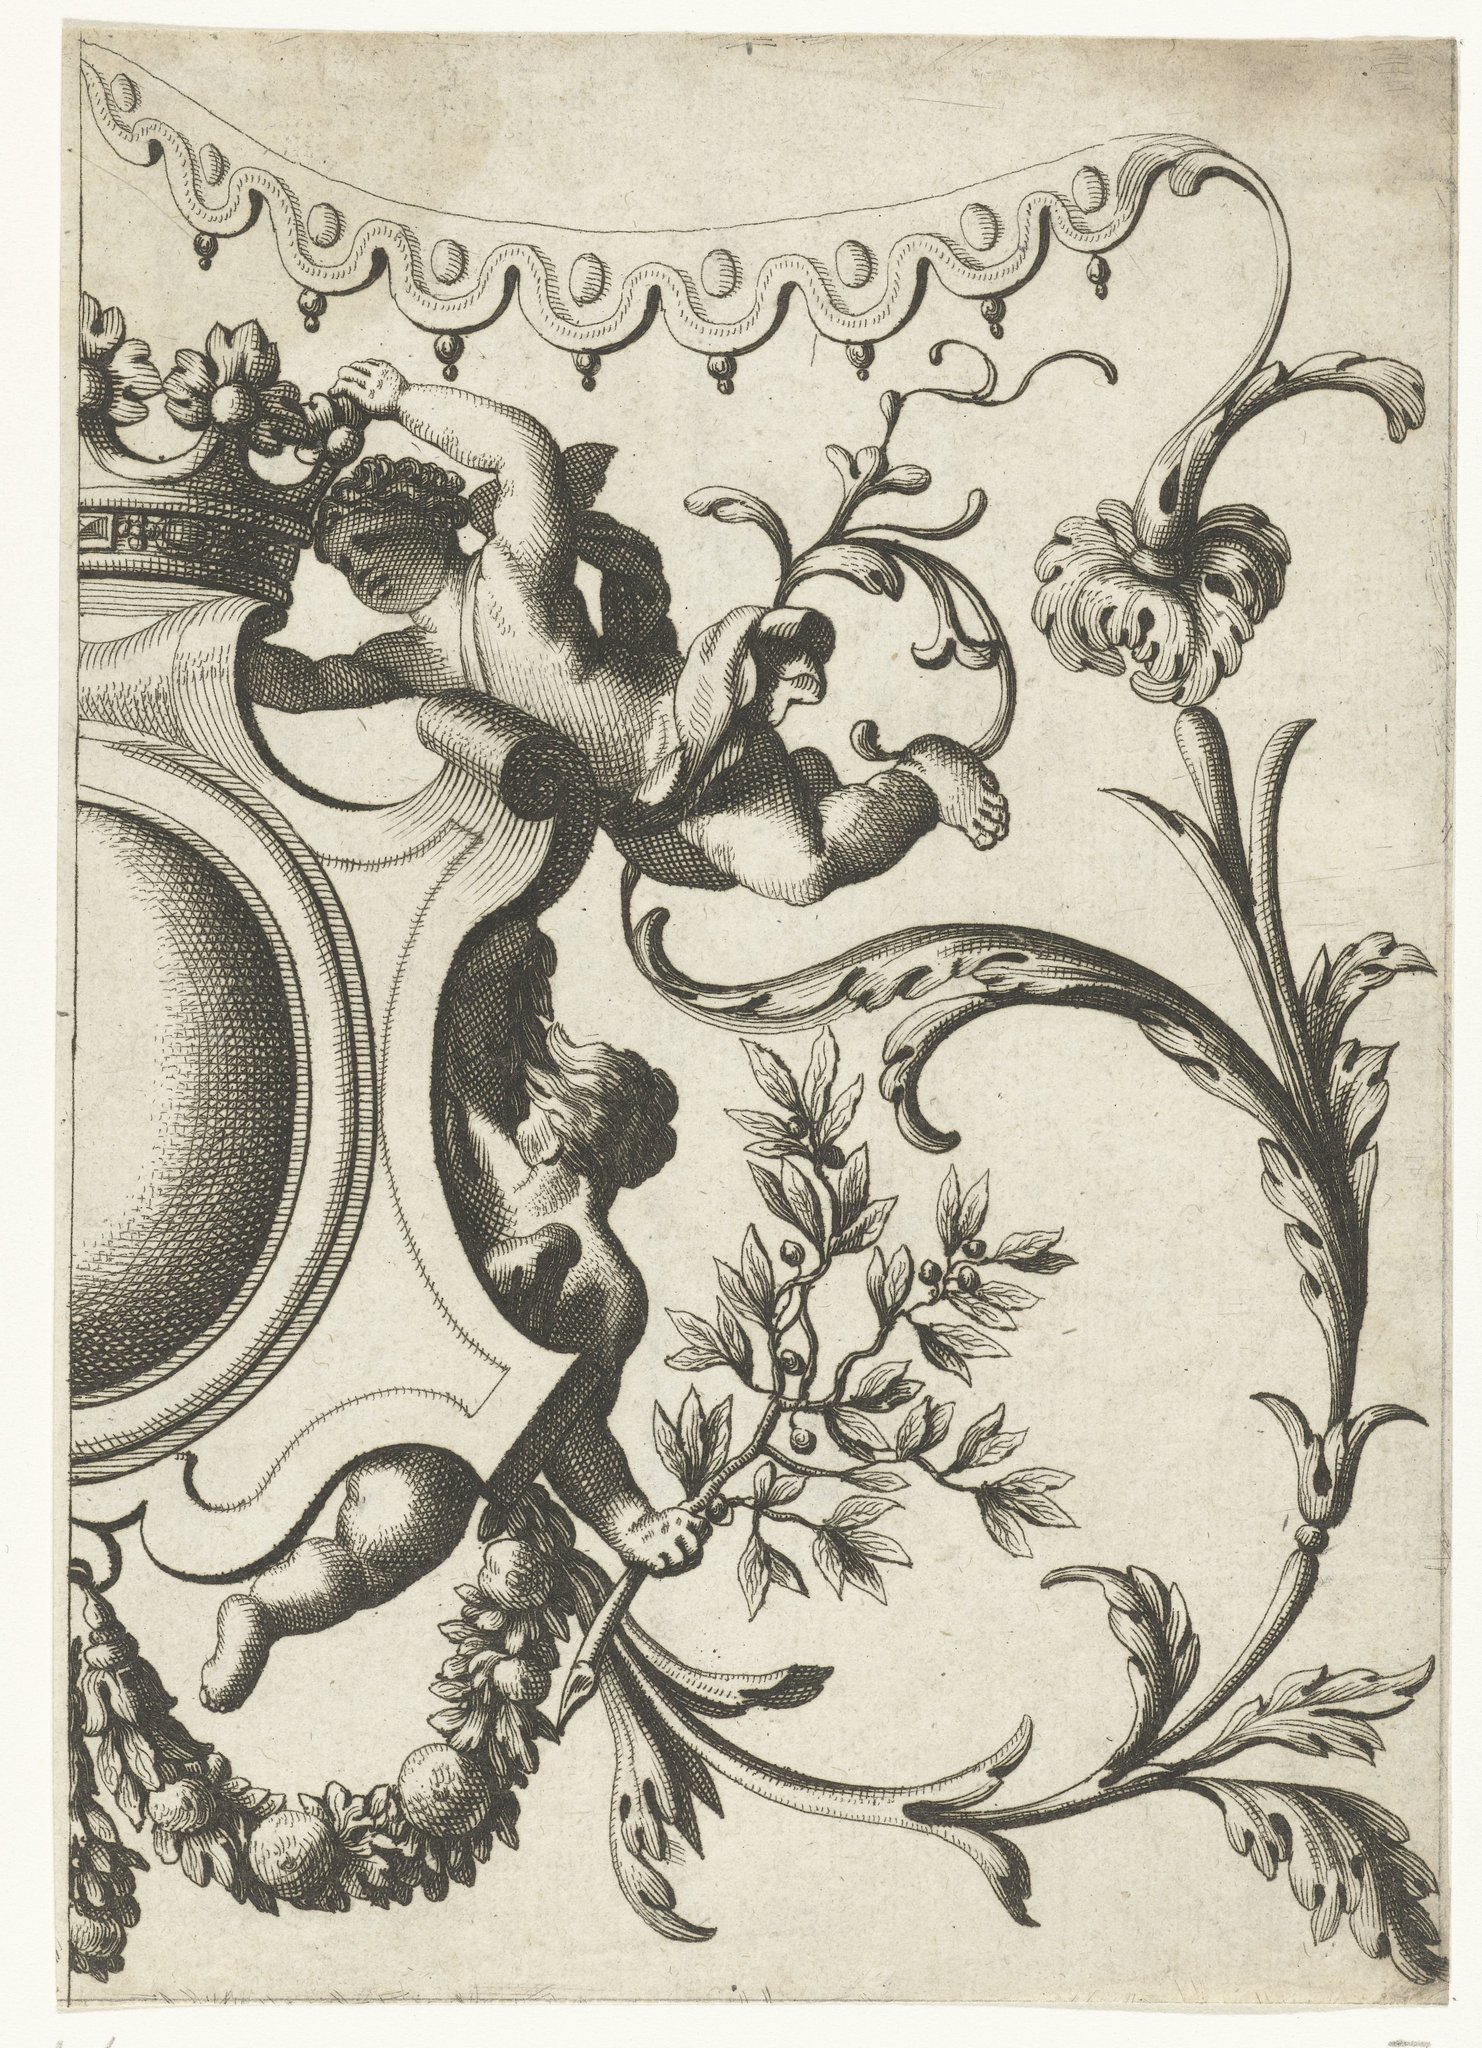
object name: ornament print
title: Rechterhelft van paneel met cartouche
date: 1628-1682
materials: paper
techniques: etching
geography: france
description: Naast de cartouche zweven twee putti, de bovenste houdt een open kroon vast.